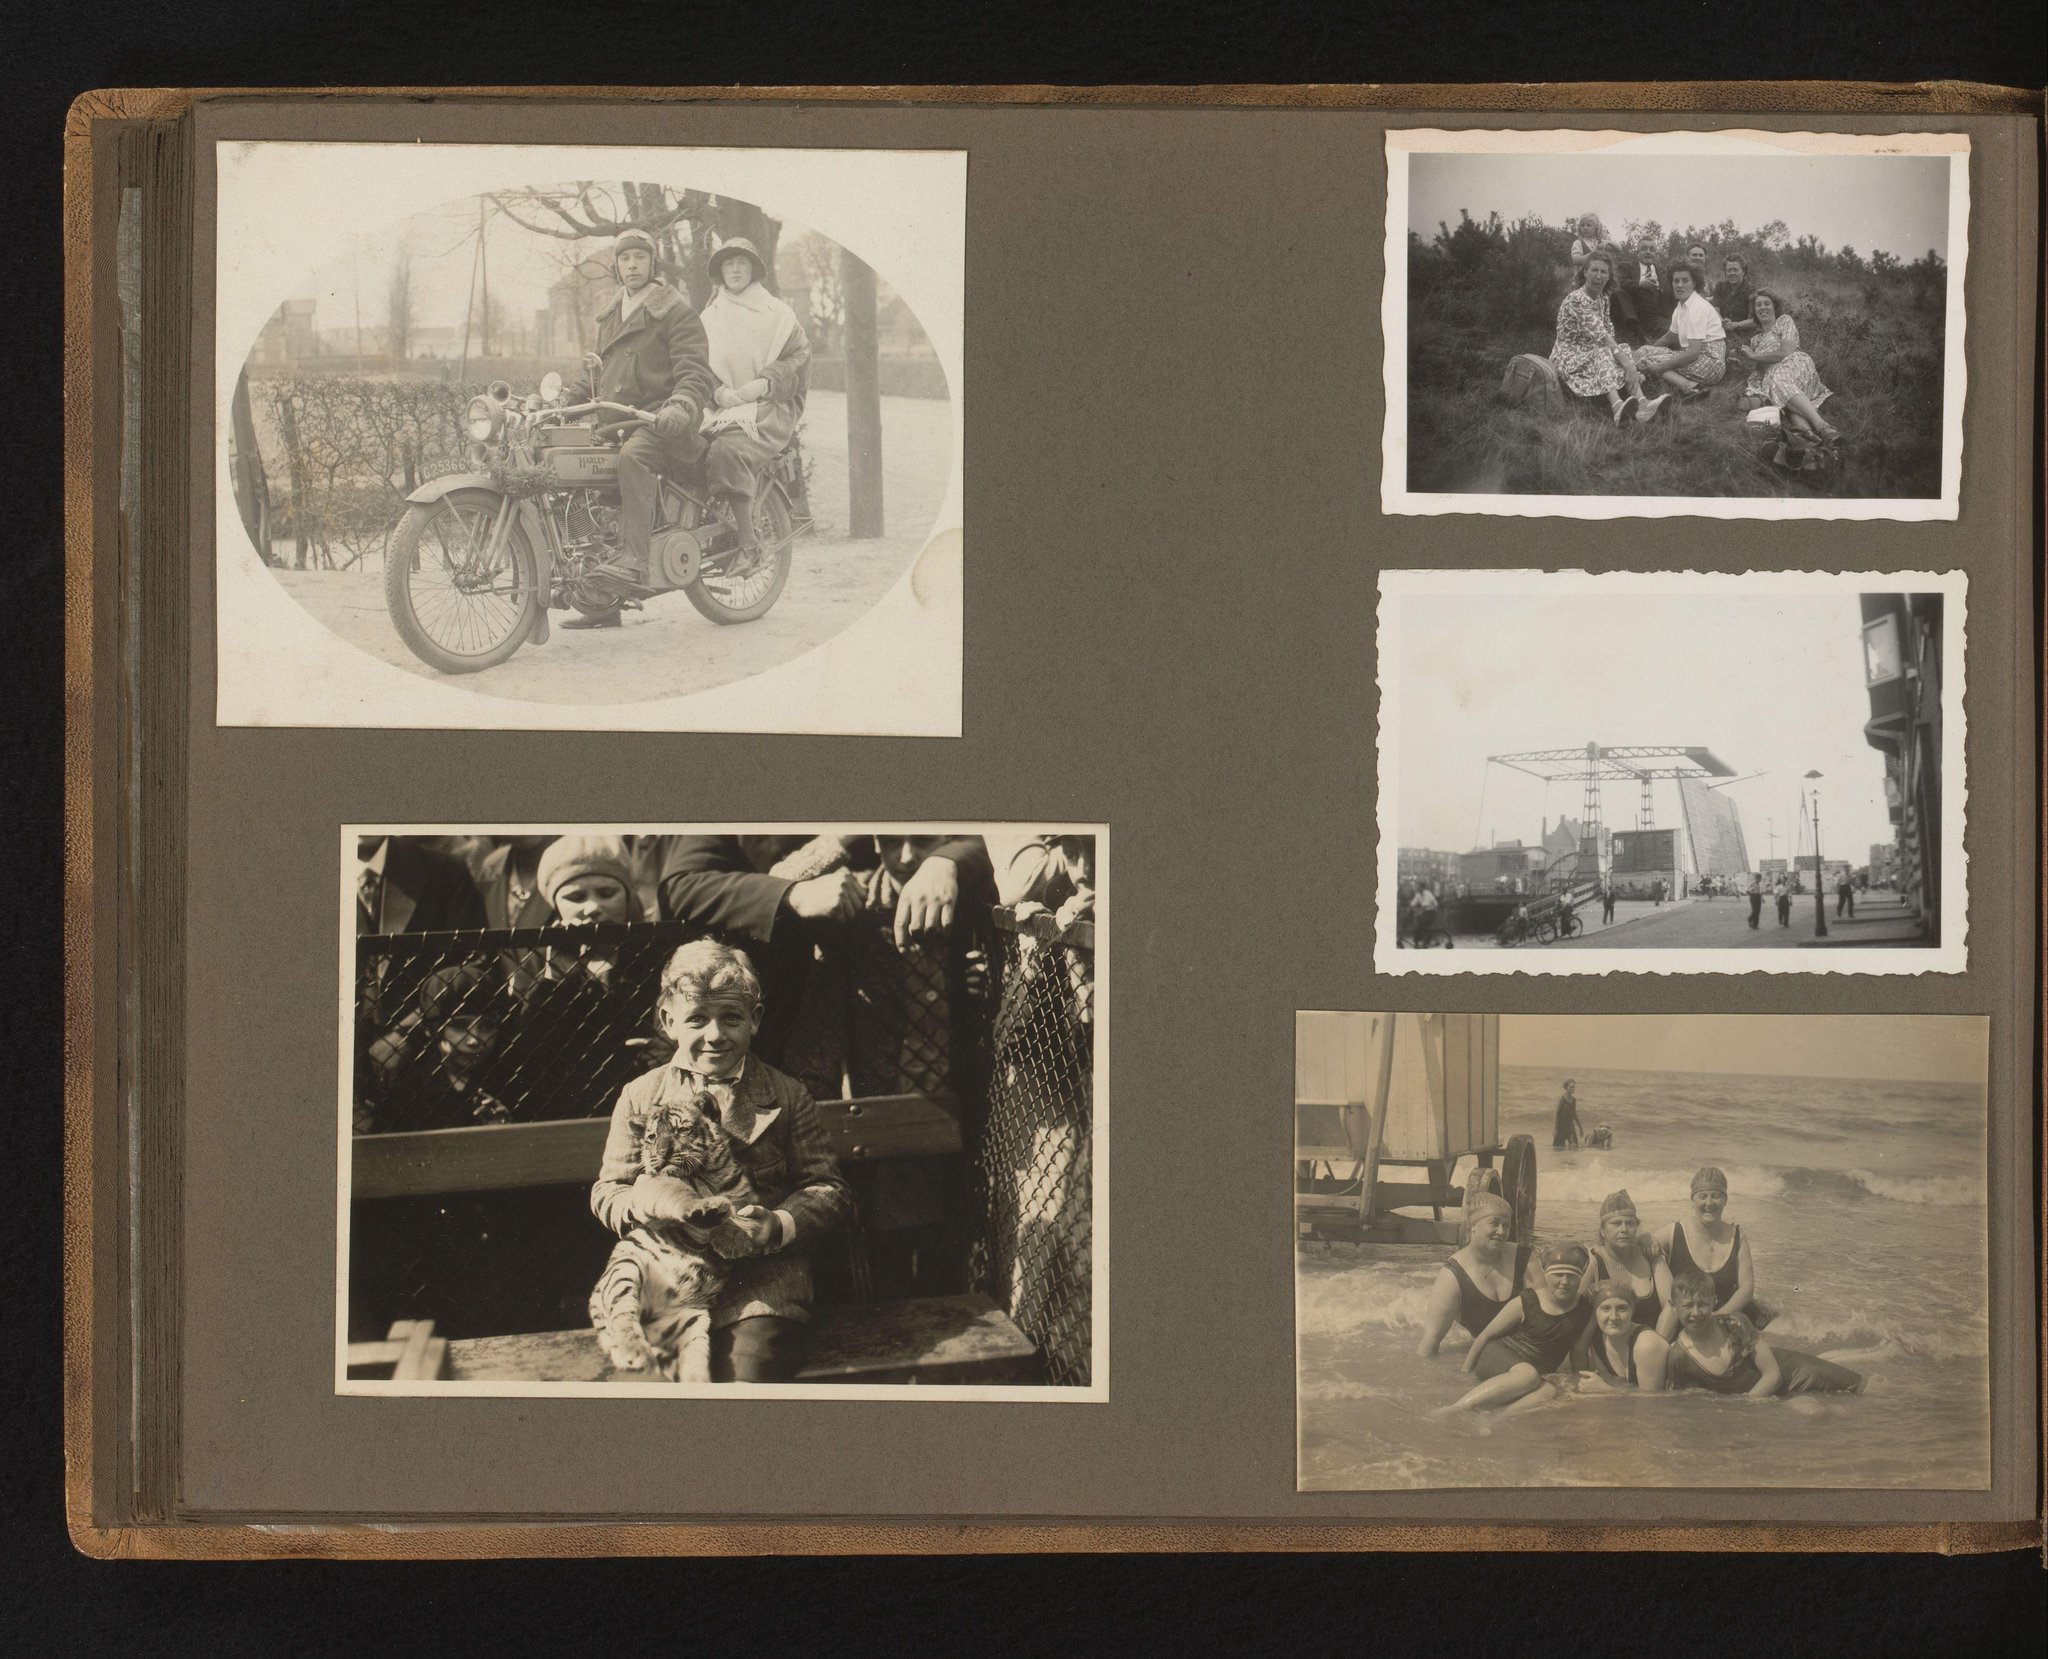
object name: album leaf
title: Diverse afbeeldingen waaronder een portret van een jongen met een jonge tijger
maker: Anonymous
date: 1900-1950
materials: photographic support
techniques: gelatin silver print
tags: adult woman, motor-cycles and other two-wheeled motor-vehicles, adult man, beasts of prey, predatory animals: tiger (+ young animal), historical persons, anonymous historical persons portrayed in a group, in a group-portrait, sea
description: Portret van een man en vouw op een motor, een groepsportret, een straatgezicht en een groepsportret in de zee. Deze pagina maakt deel uit van een album.